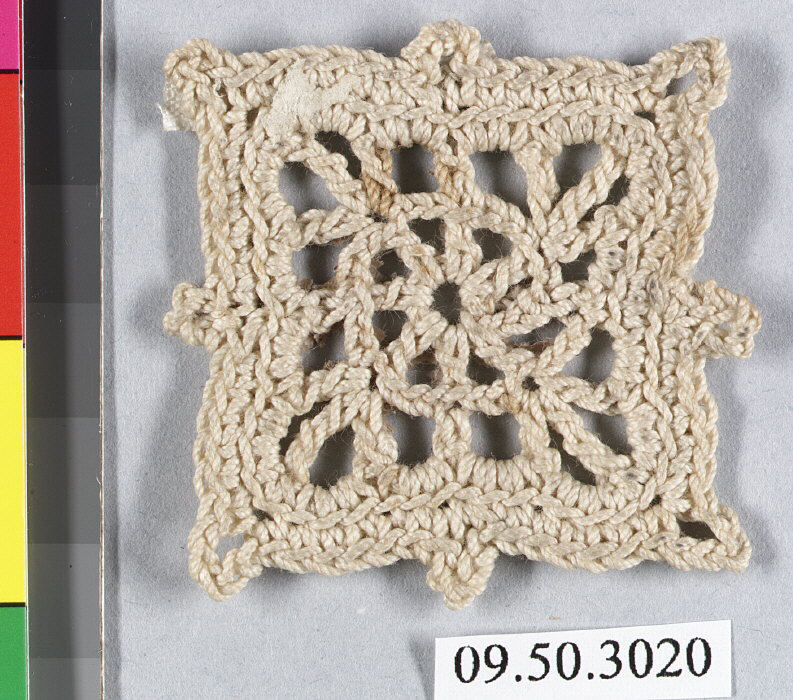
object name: sample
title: Crochet work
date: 1801-1900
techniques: crochet